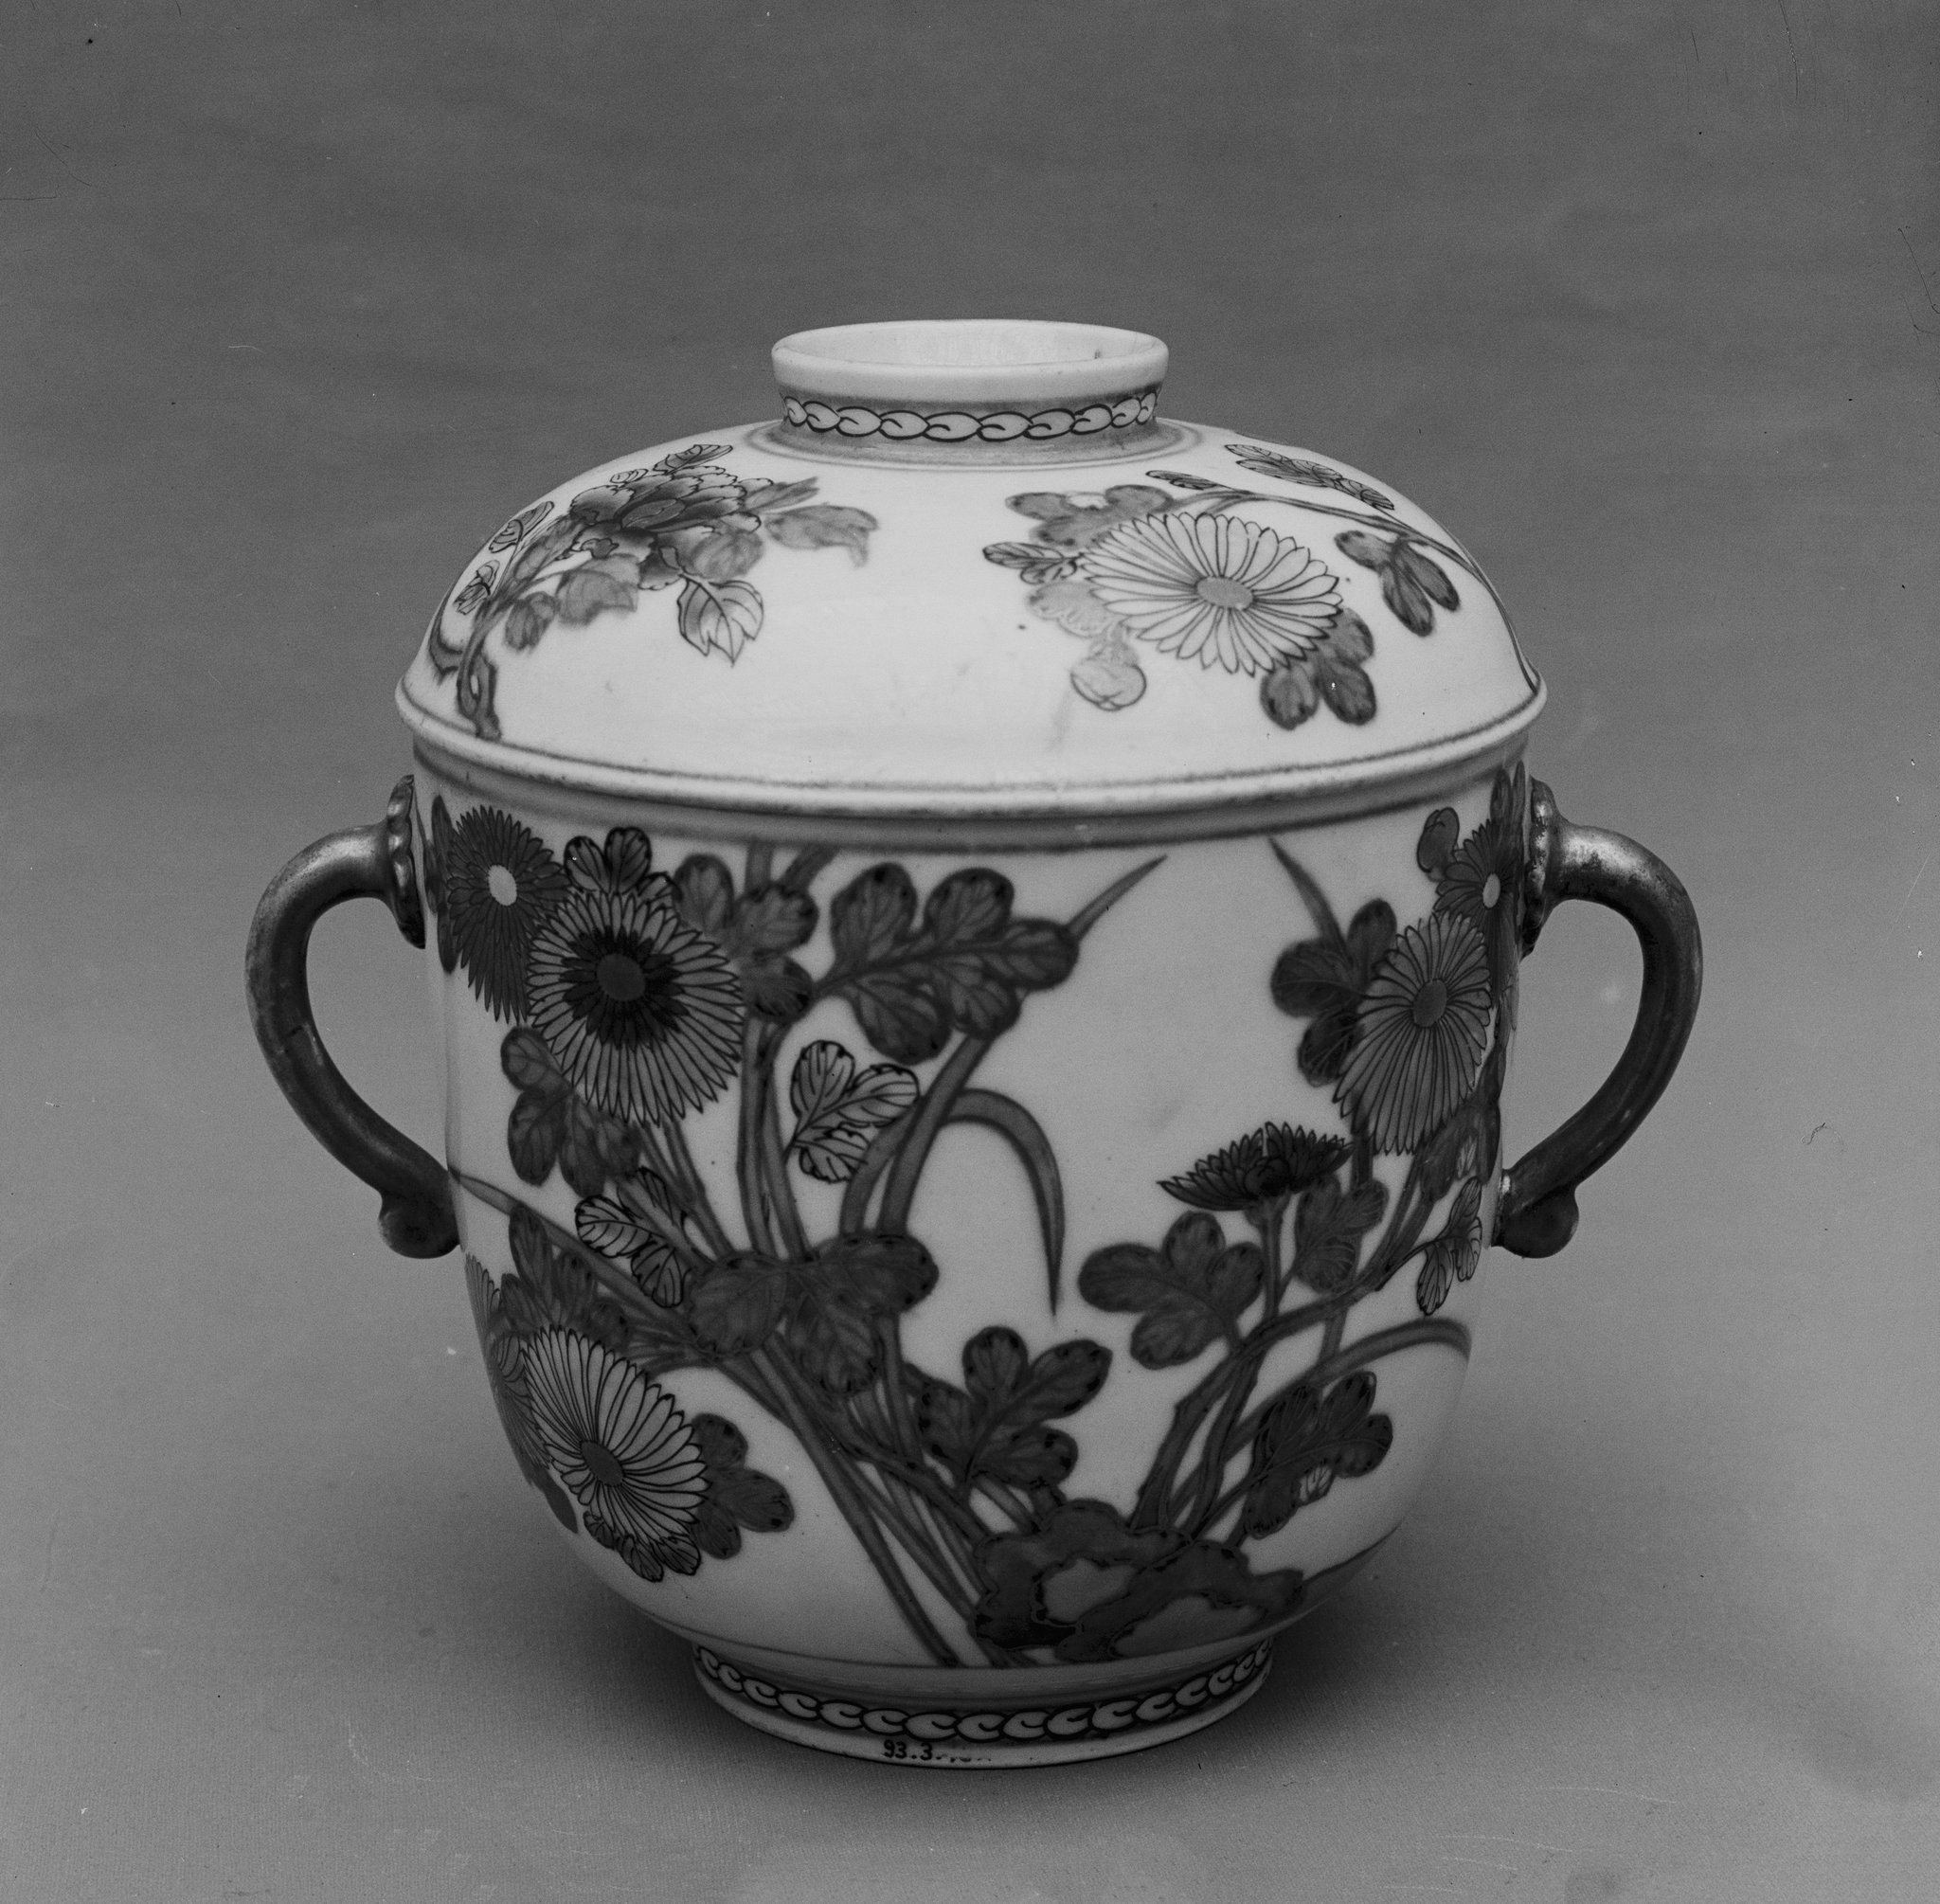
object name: cup with cover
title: Cup and Cover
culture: japanese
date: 1780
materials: enamel, glaze, porcelain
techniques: polychrome